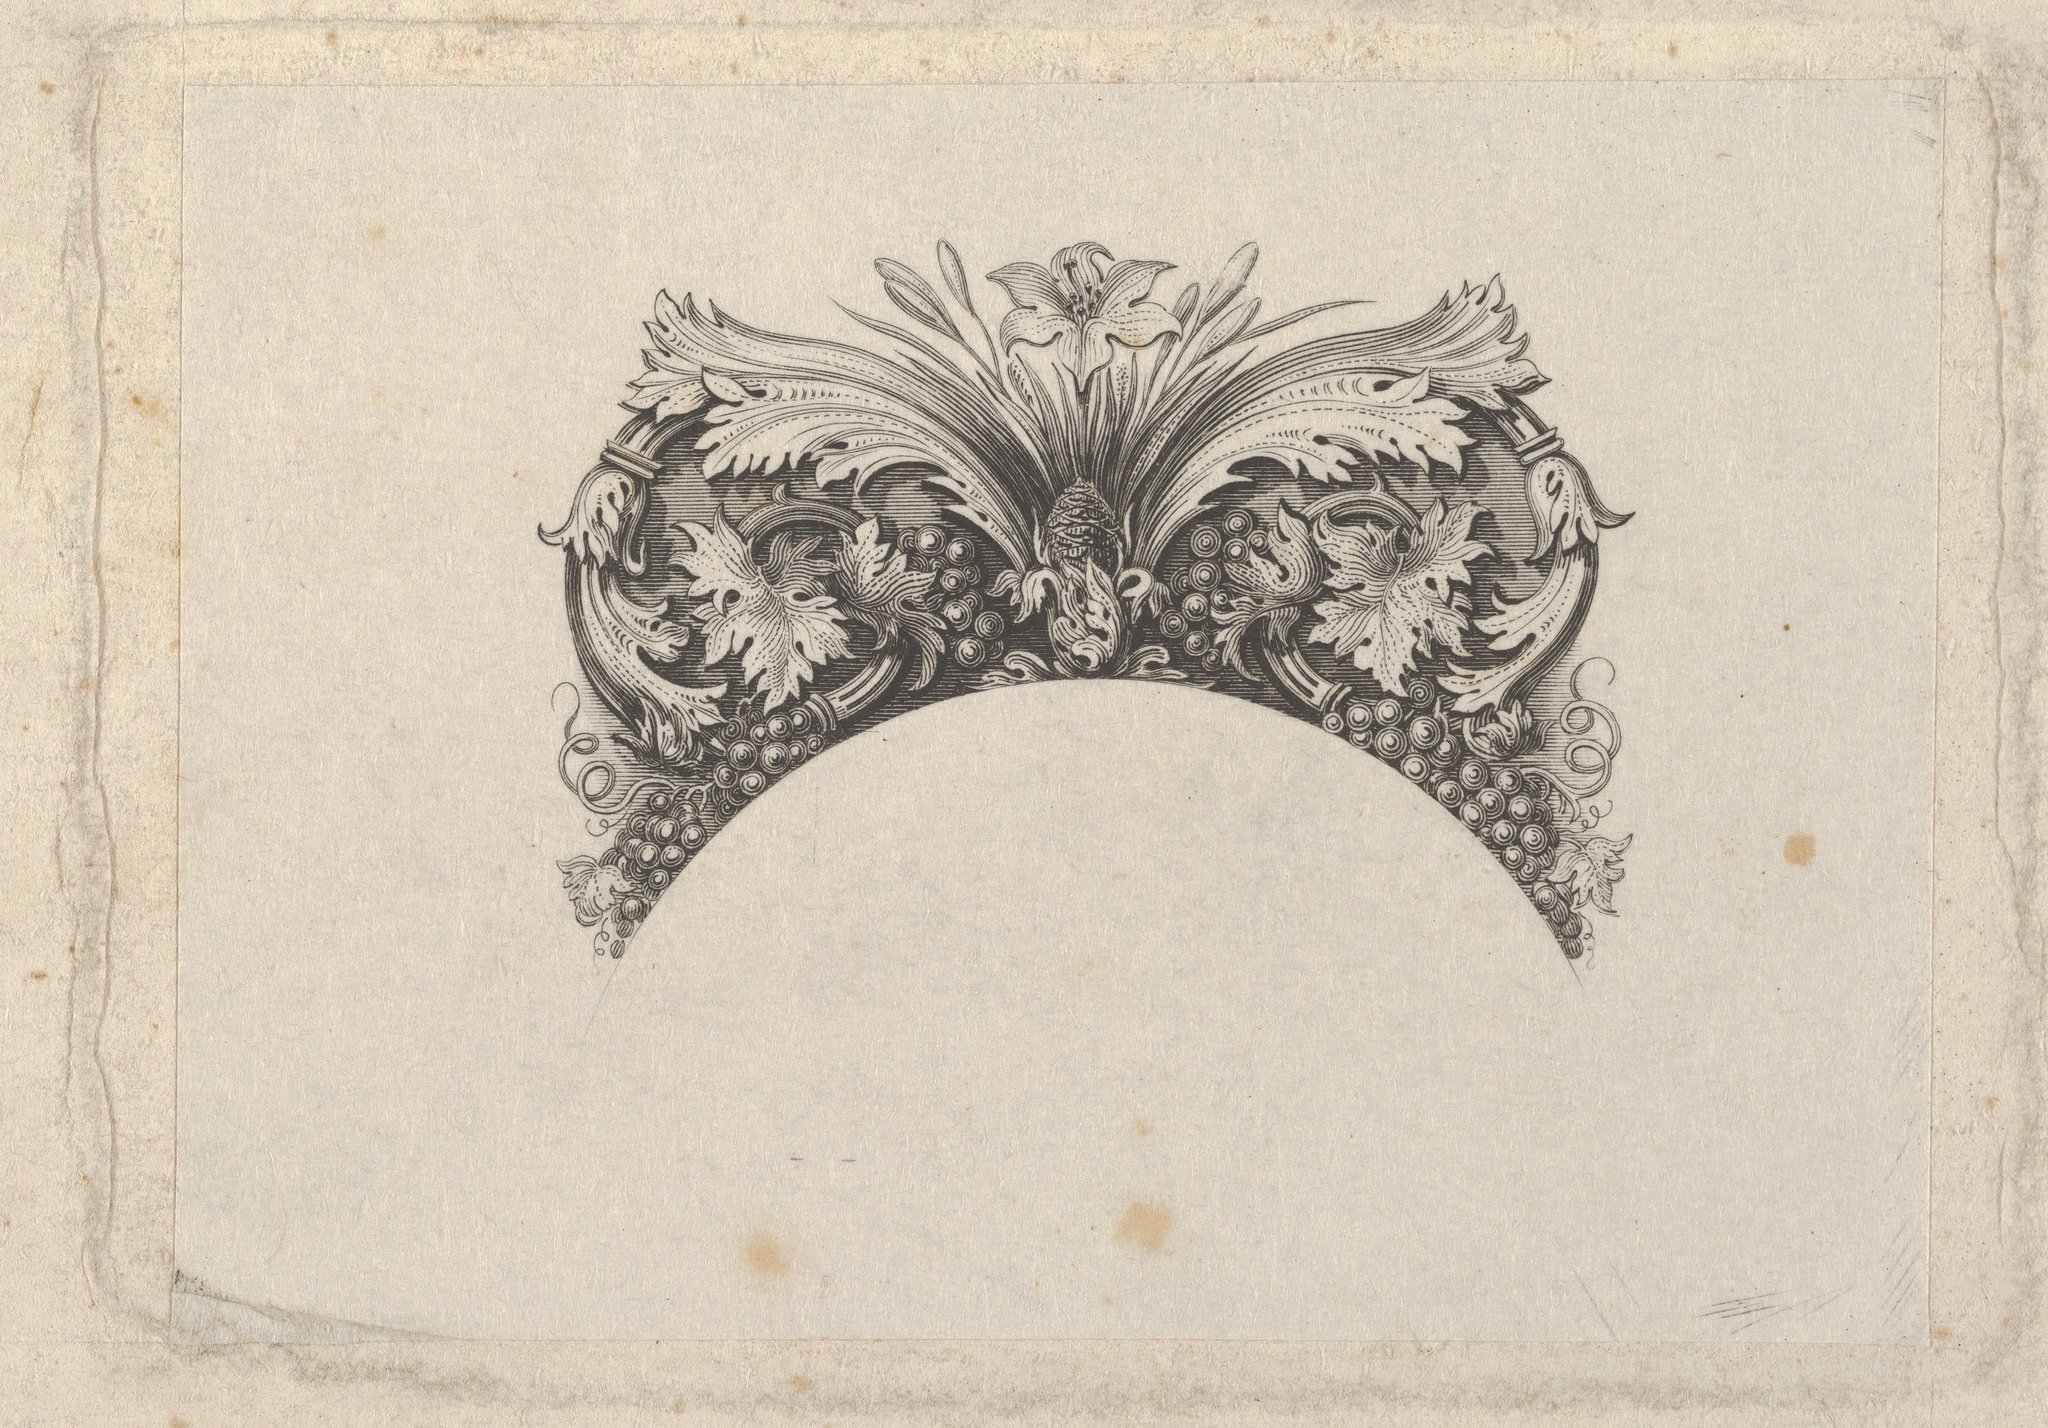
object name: print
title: Arched framing element for banknote, with acanthus and vine leaves, lily and grapes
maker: asher brown durand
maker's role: artist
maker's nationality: american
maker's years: 1796-1886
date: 1824-1837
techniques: engraving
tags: grapes,lilies,vines